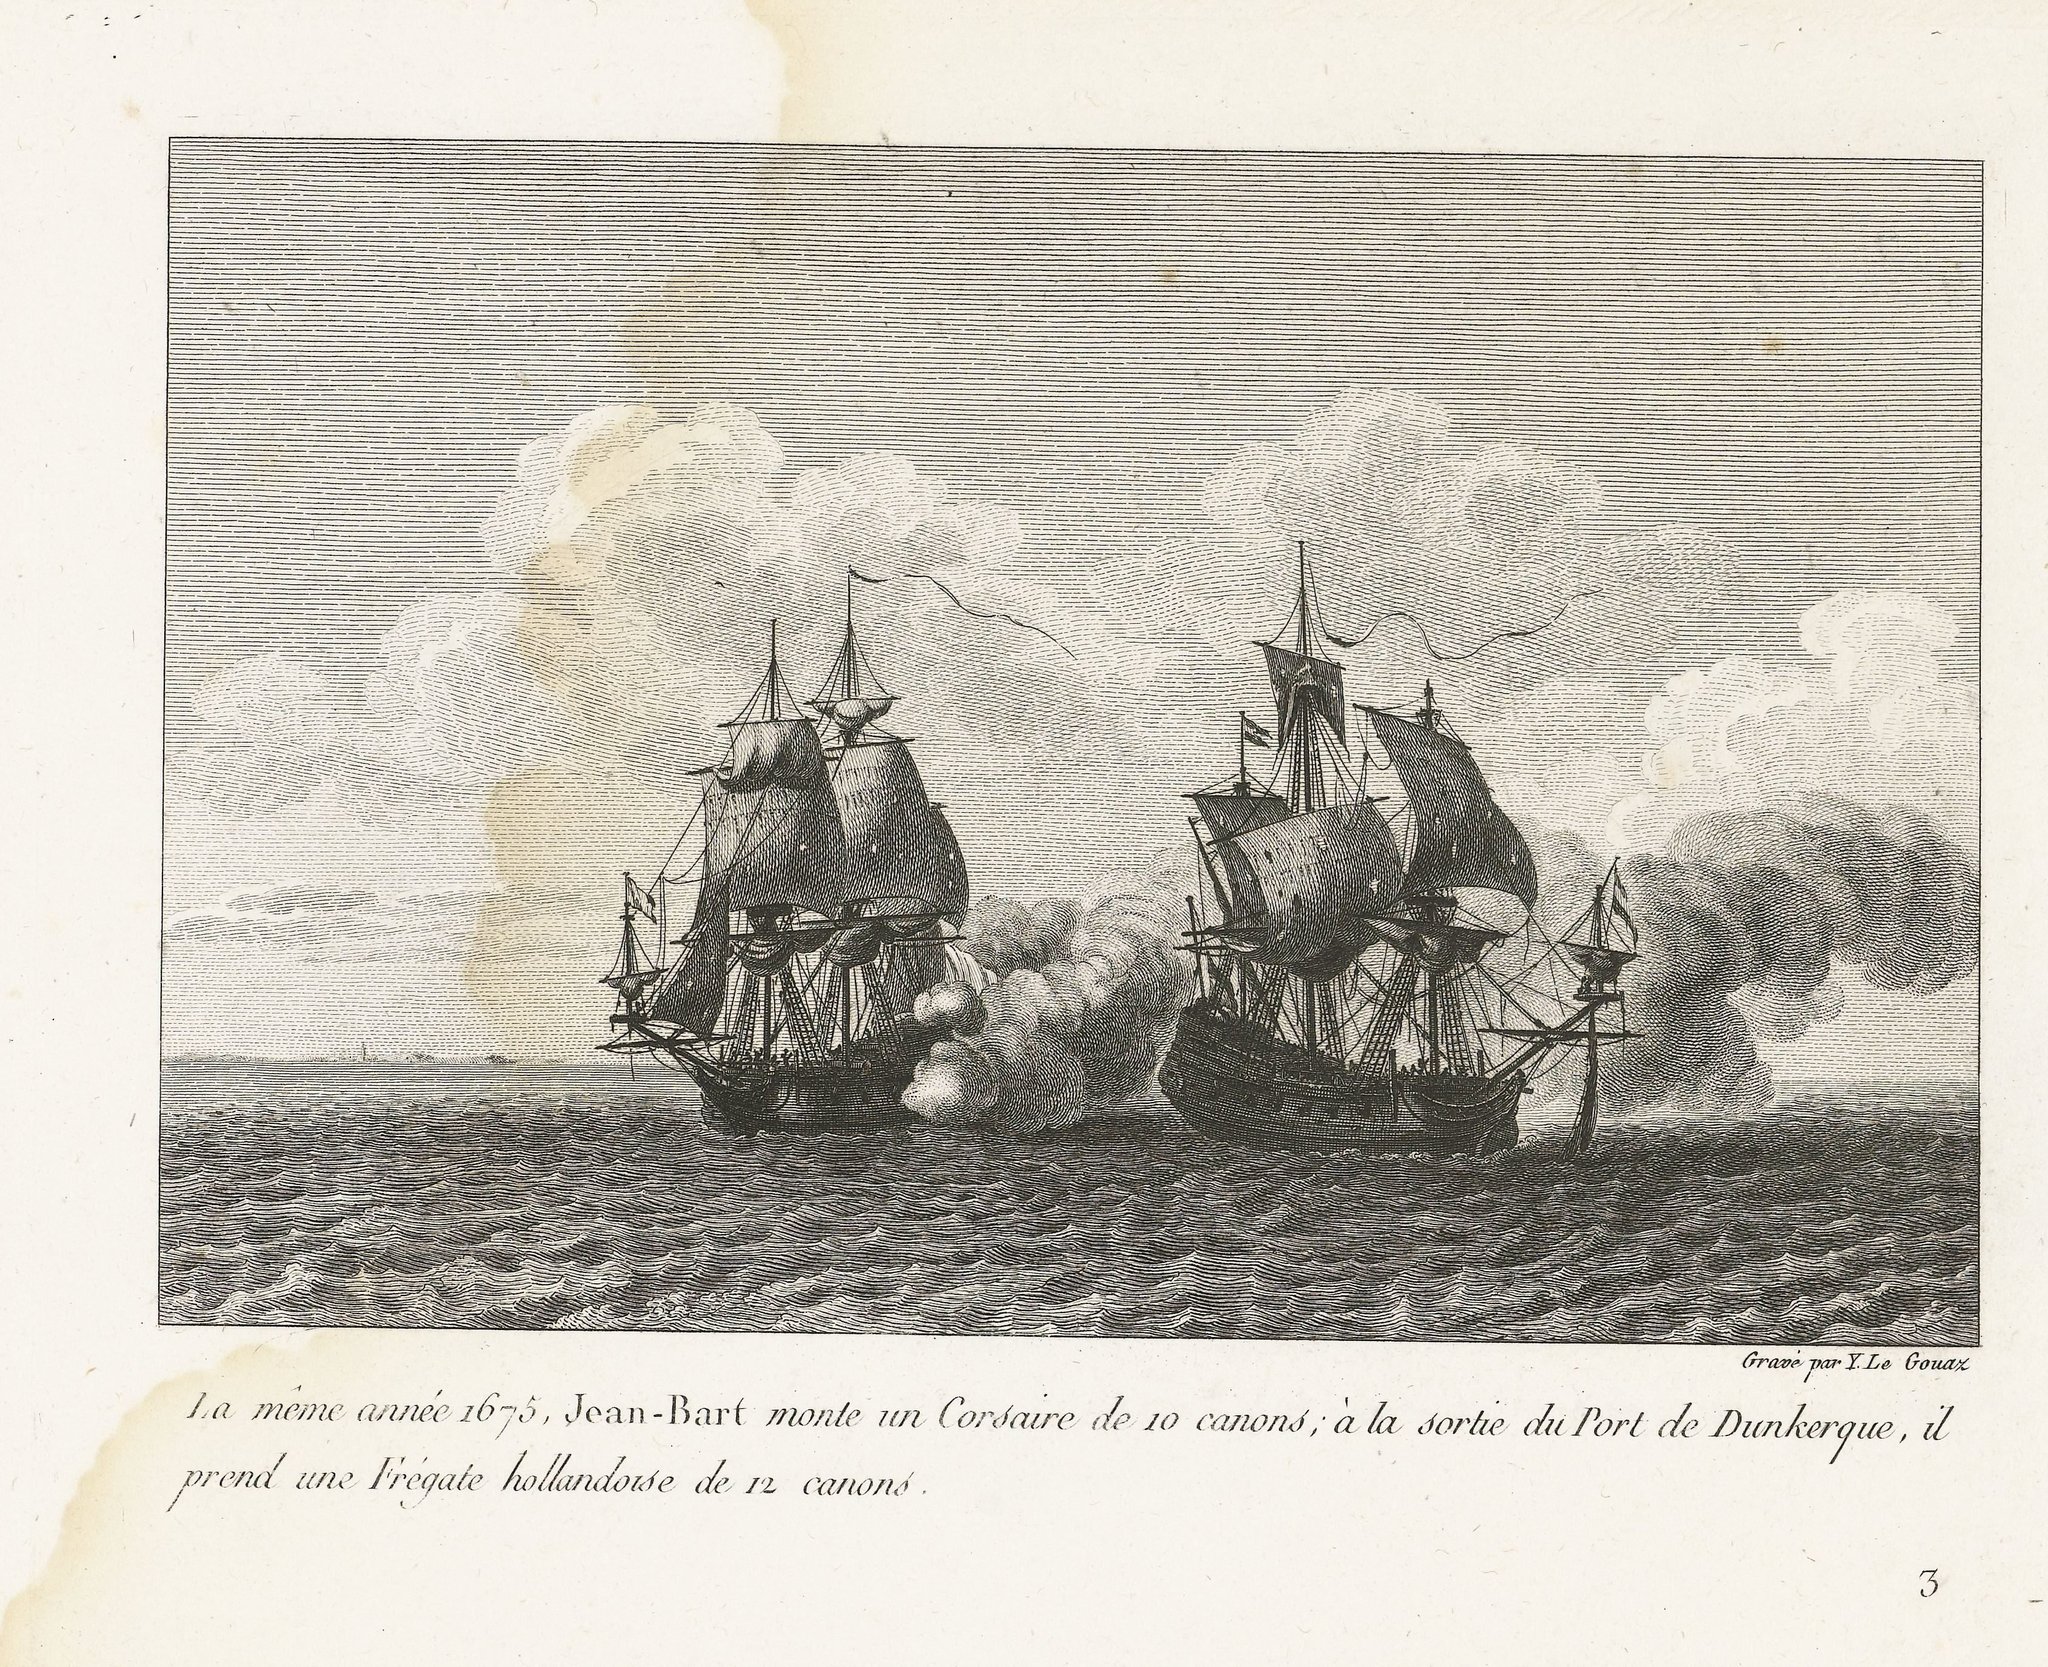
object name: history print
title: Jan Bart verovert een Hollands fregat bij Duinkerke, 1675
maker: yves marie le gouaz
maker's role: print maker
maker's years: 1742-1816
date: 1806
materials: paper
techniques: etching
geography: paris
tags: battle (+ naval force)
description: Jan Bart verovert een Hollands fregat bij de toegang tot de haven van Duinkerke, 1675. Onderdeel van een serie over de daden van de Vlaamse kaper in Franse dienst Jan Bart.